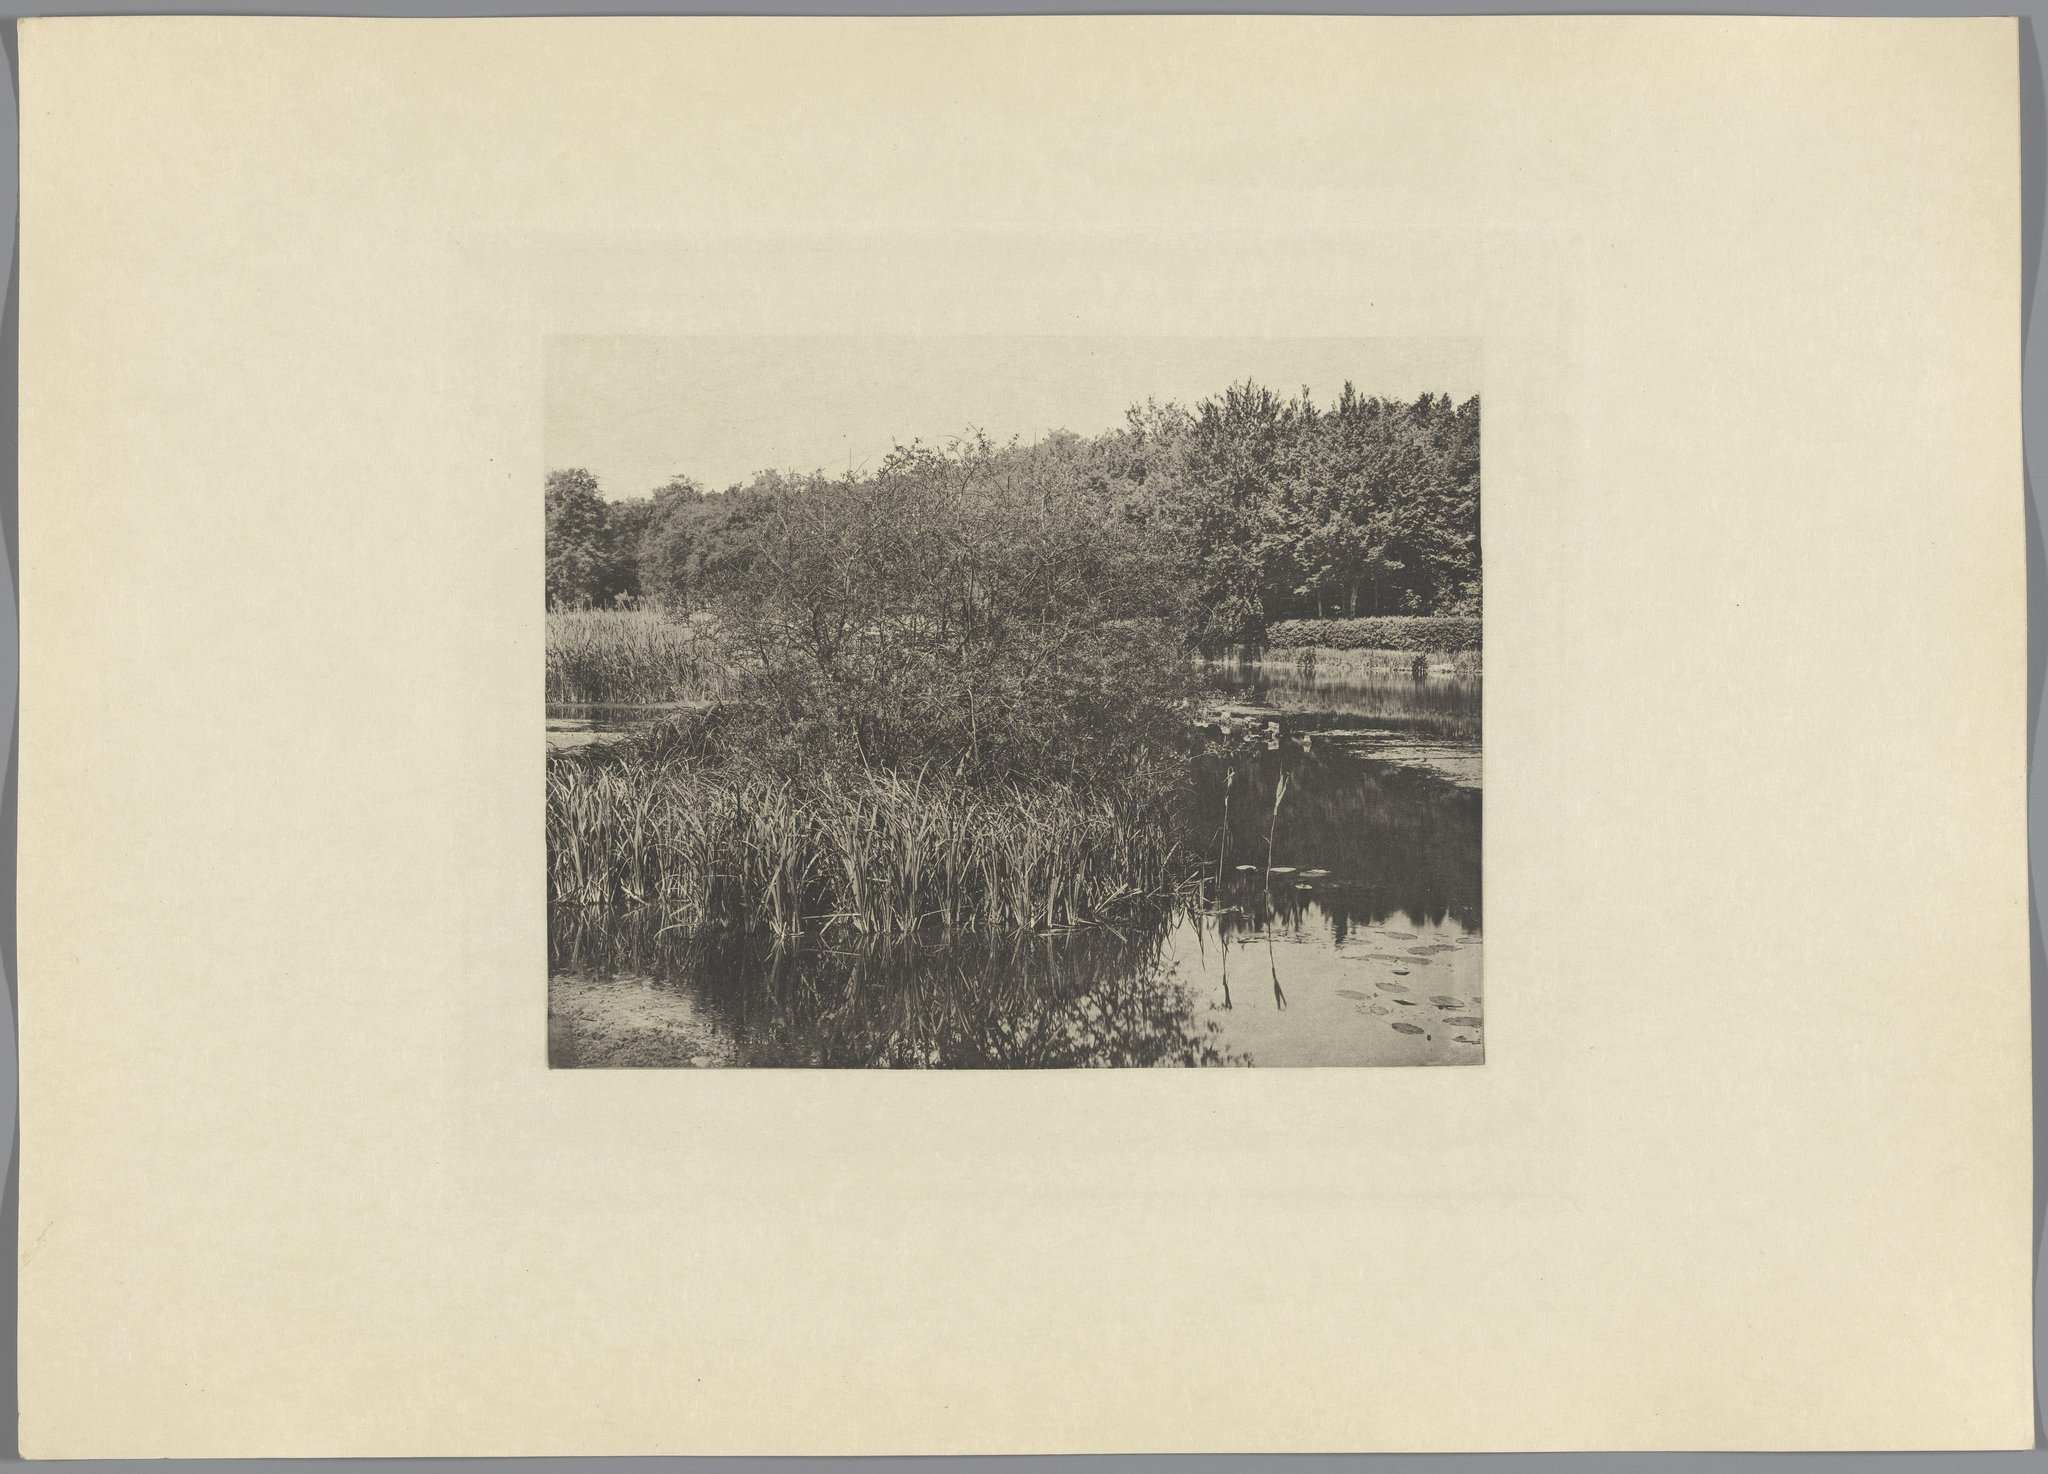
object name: photomechanical print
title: Étang de Commelles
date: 1891-1896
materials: paper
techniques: photoaquatint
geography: paris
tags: shrubs, lake